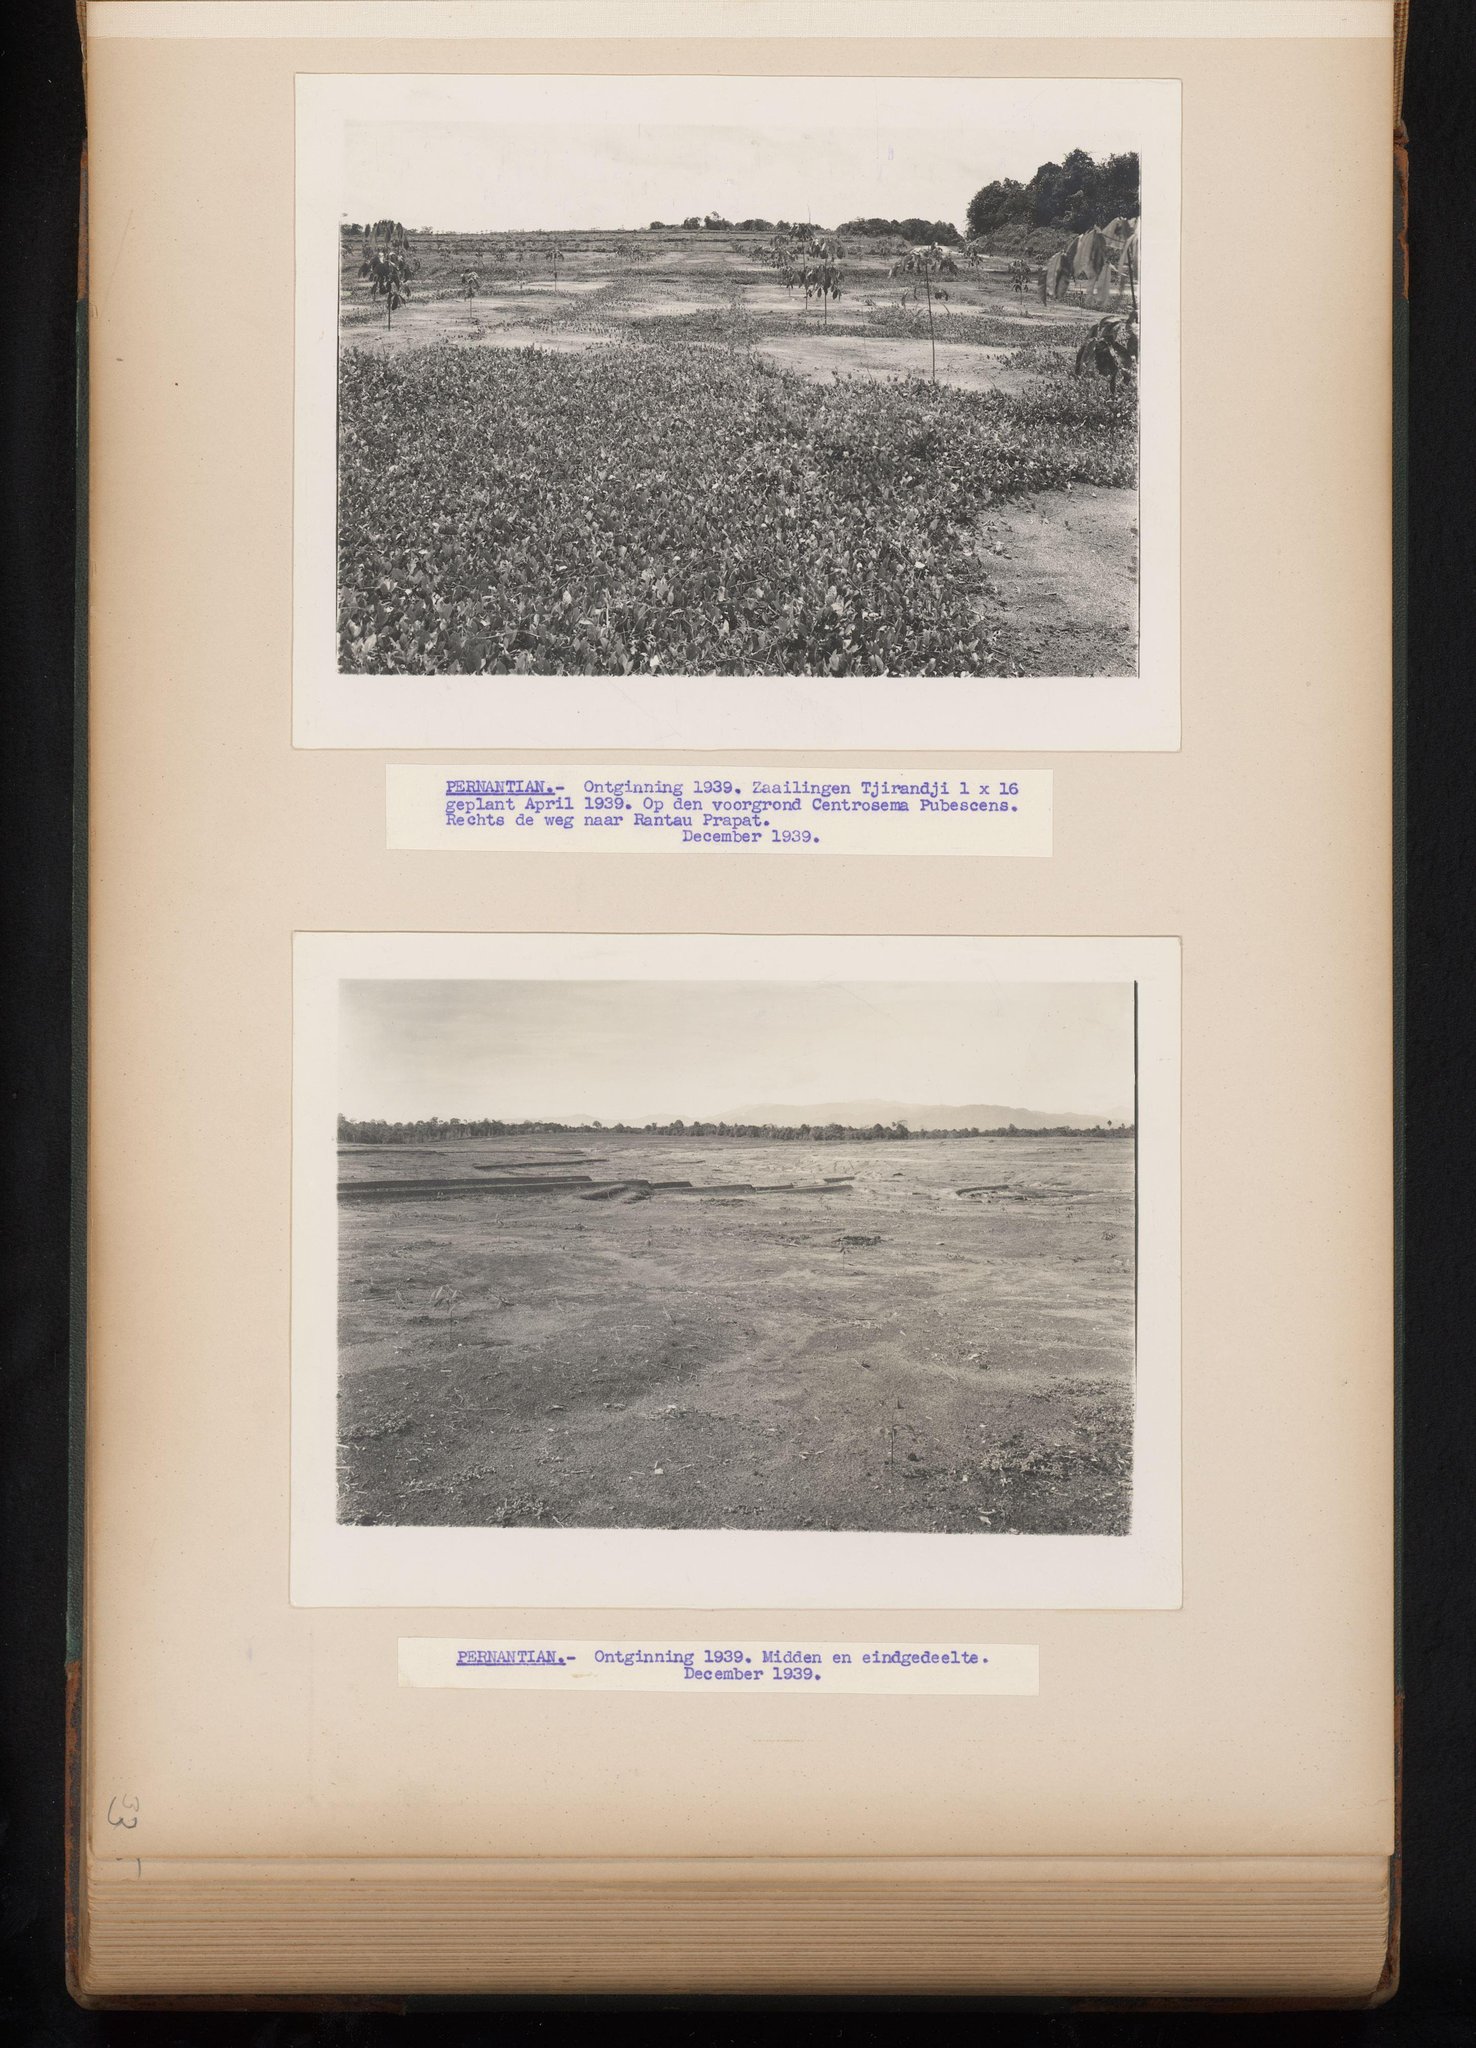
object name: photograph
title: Ontginning op Pernantian, 1939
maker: Anonymous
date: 1912-1939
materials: cardboard, photographic support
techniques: gelatin silver print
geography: sumatra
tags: plantation, (non-fruit) products of plants or trees: rubber, sumatra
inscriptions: inscription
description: Blad met twee foto's van ontginning nieuwe akkers met rubberbomen op Pernantian, december 1939. Met etiketten met onderschriften onder de foto's. Onderdeel van het fotoalbum over de plantages Pernantian en Brussel van de Sumatra Caoutchouc Maatschappij op de Oostkust van Sumatra in de jaren 1935-1939.